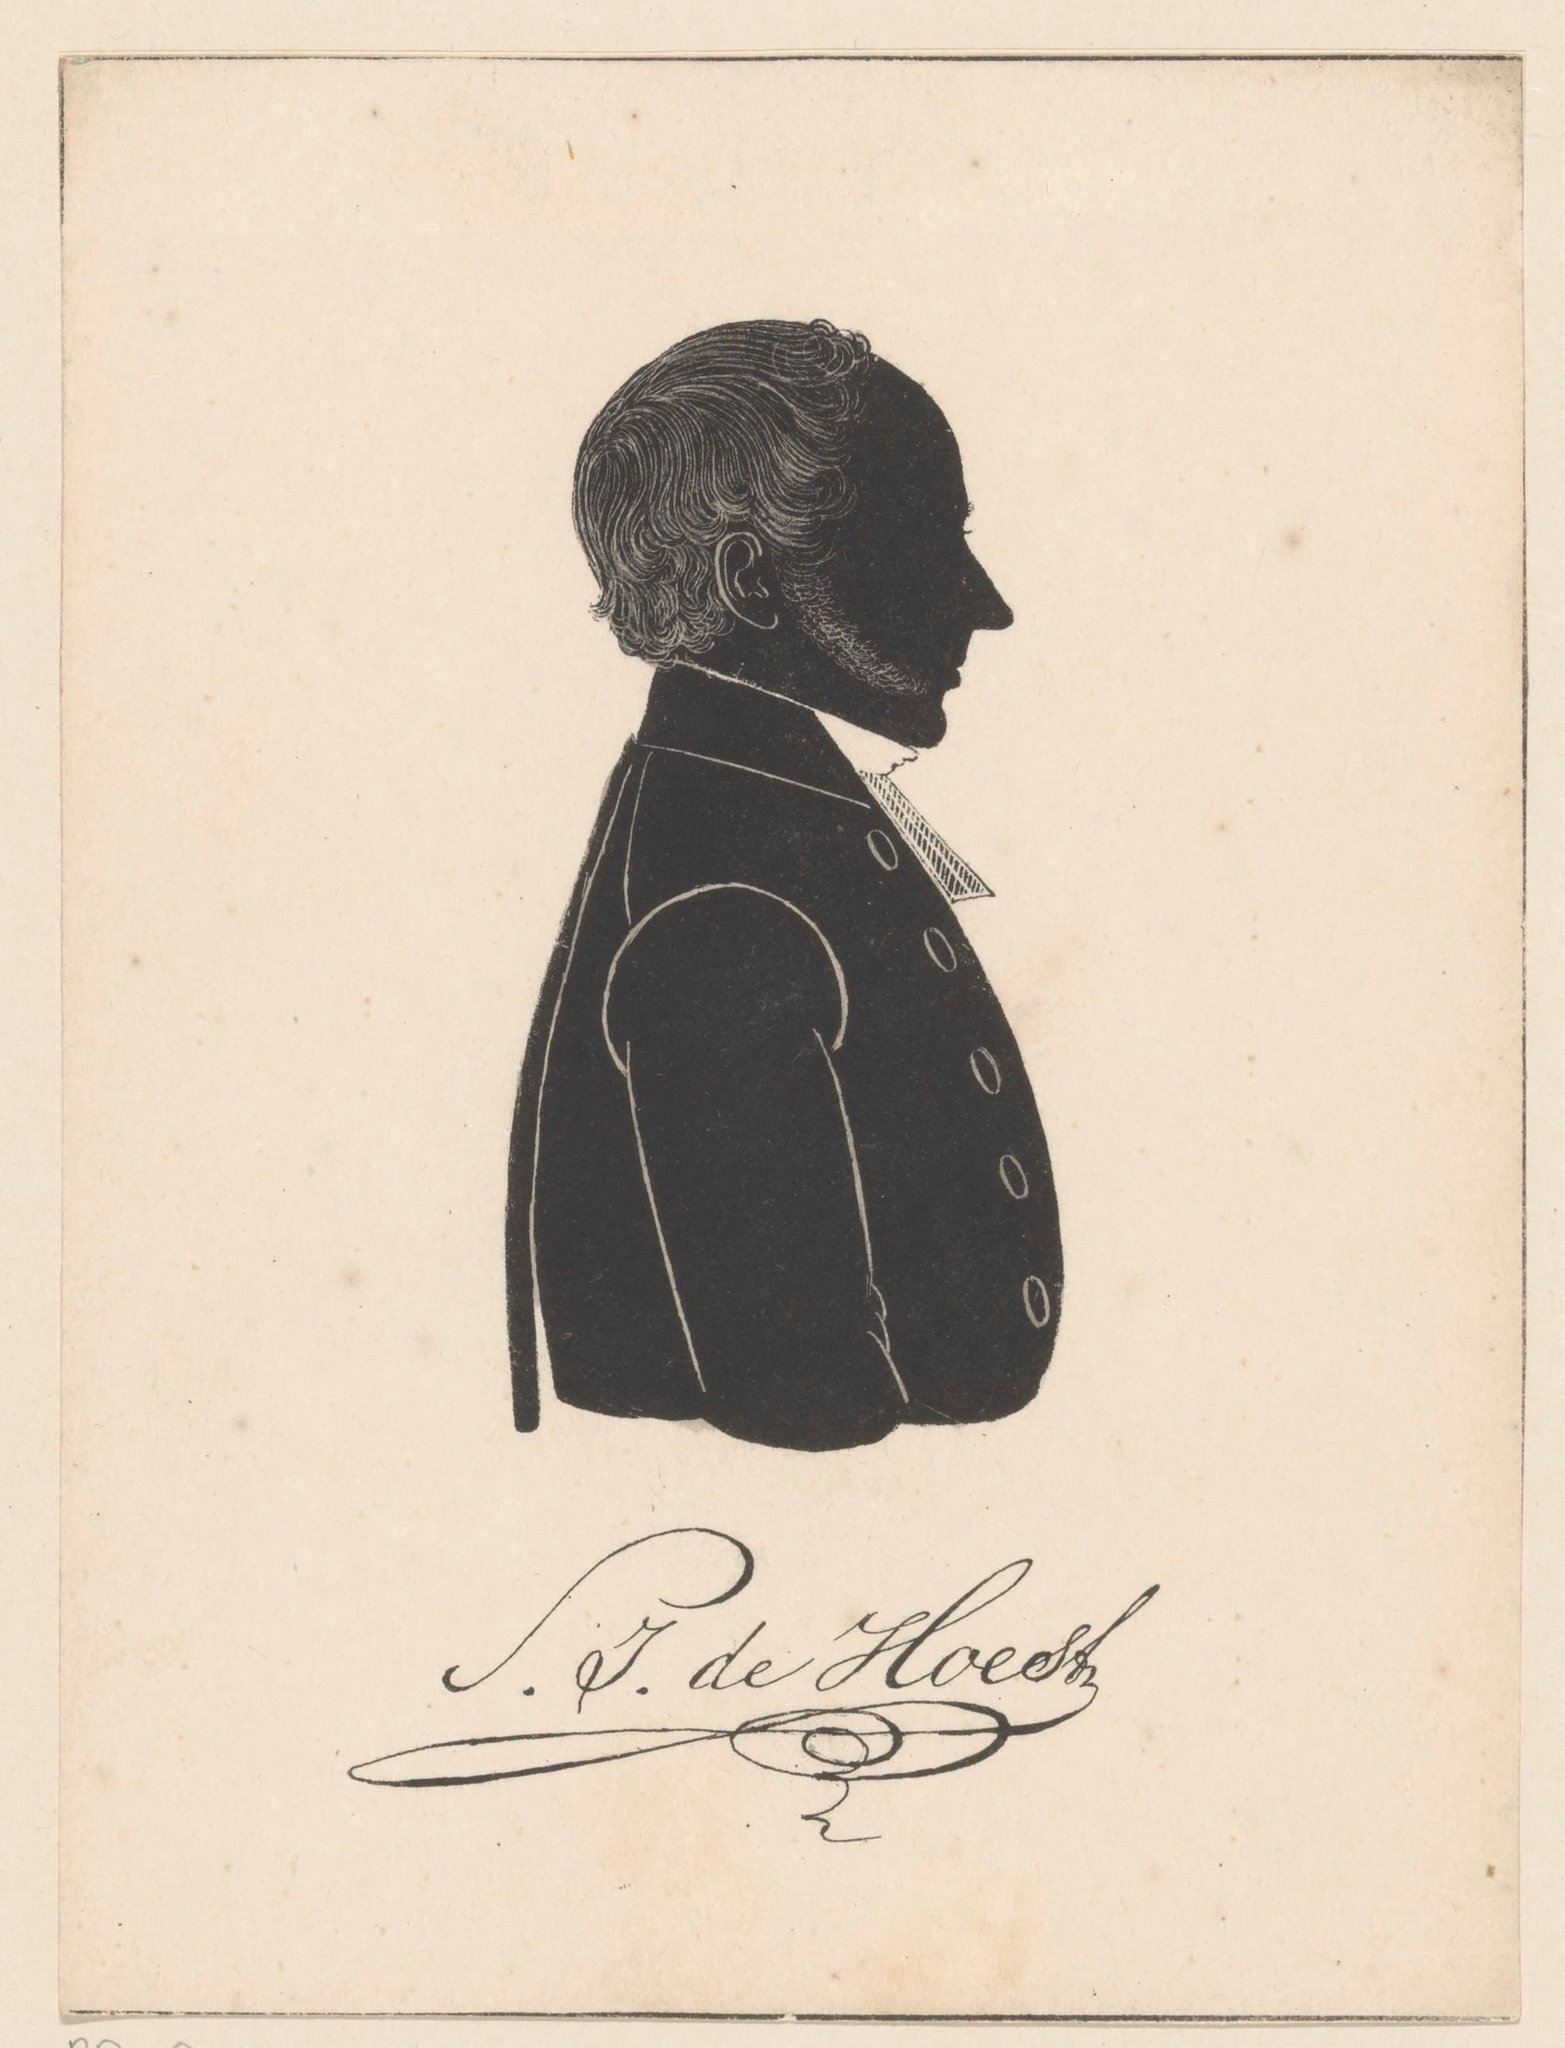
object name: print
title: Silhouetportret van Samuel Joannes de Hoest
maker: pieter barbiers (iv)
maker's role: painter, print maker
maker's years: 1798-1848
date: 1809-1848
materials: paper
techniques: hand coloring, lithograph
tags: amsterdam, historical persons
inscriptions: collector's mark: Lugt 2228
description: Onder het portret de signatuur van de geportretteerde.